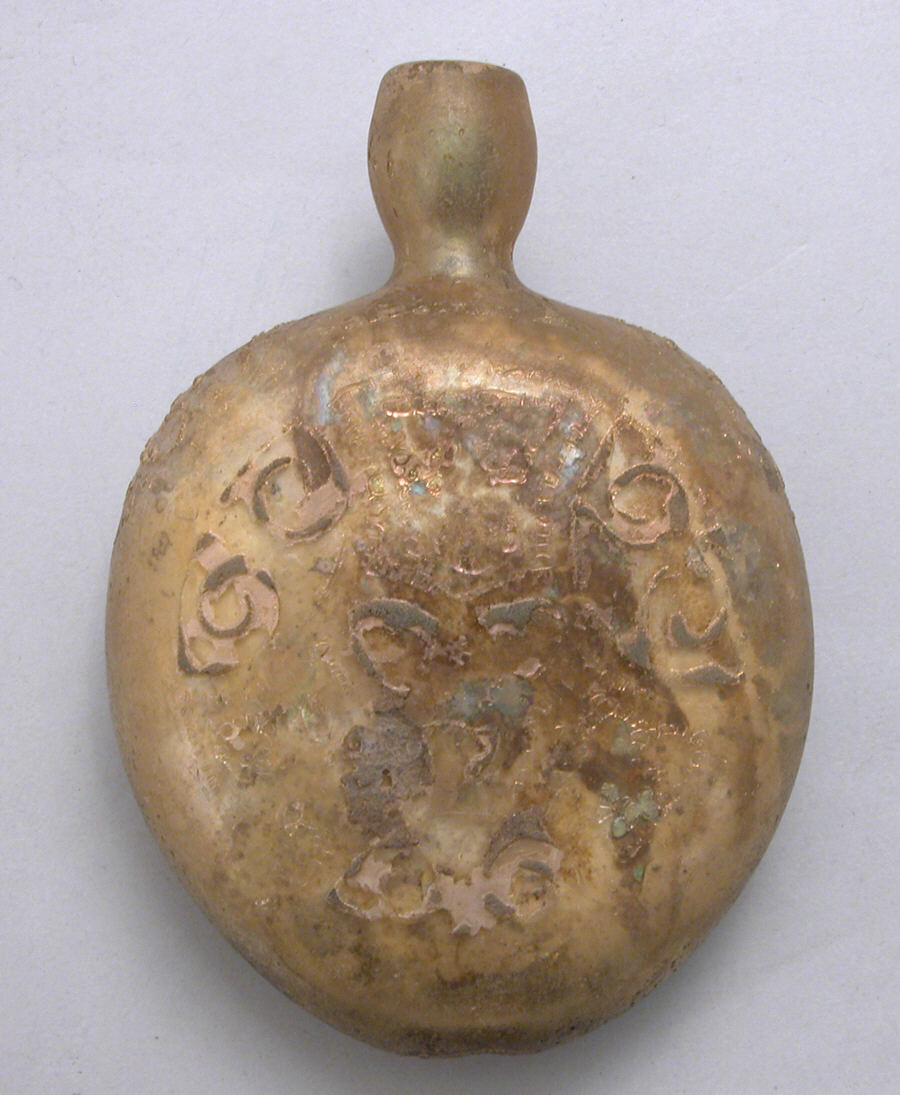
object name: flask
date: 1251-1300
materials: glass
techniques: enamel, glassblowing, gilding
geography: syria